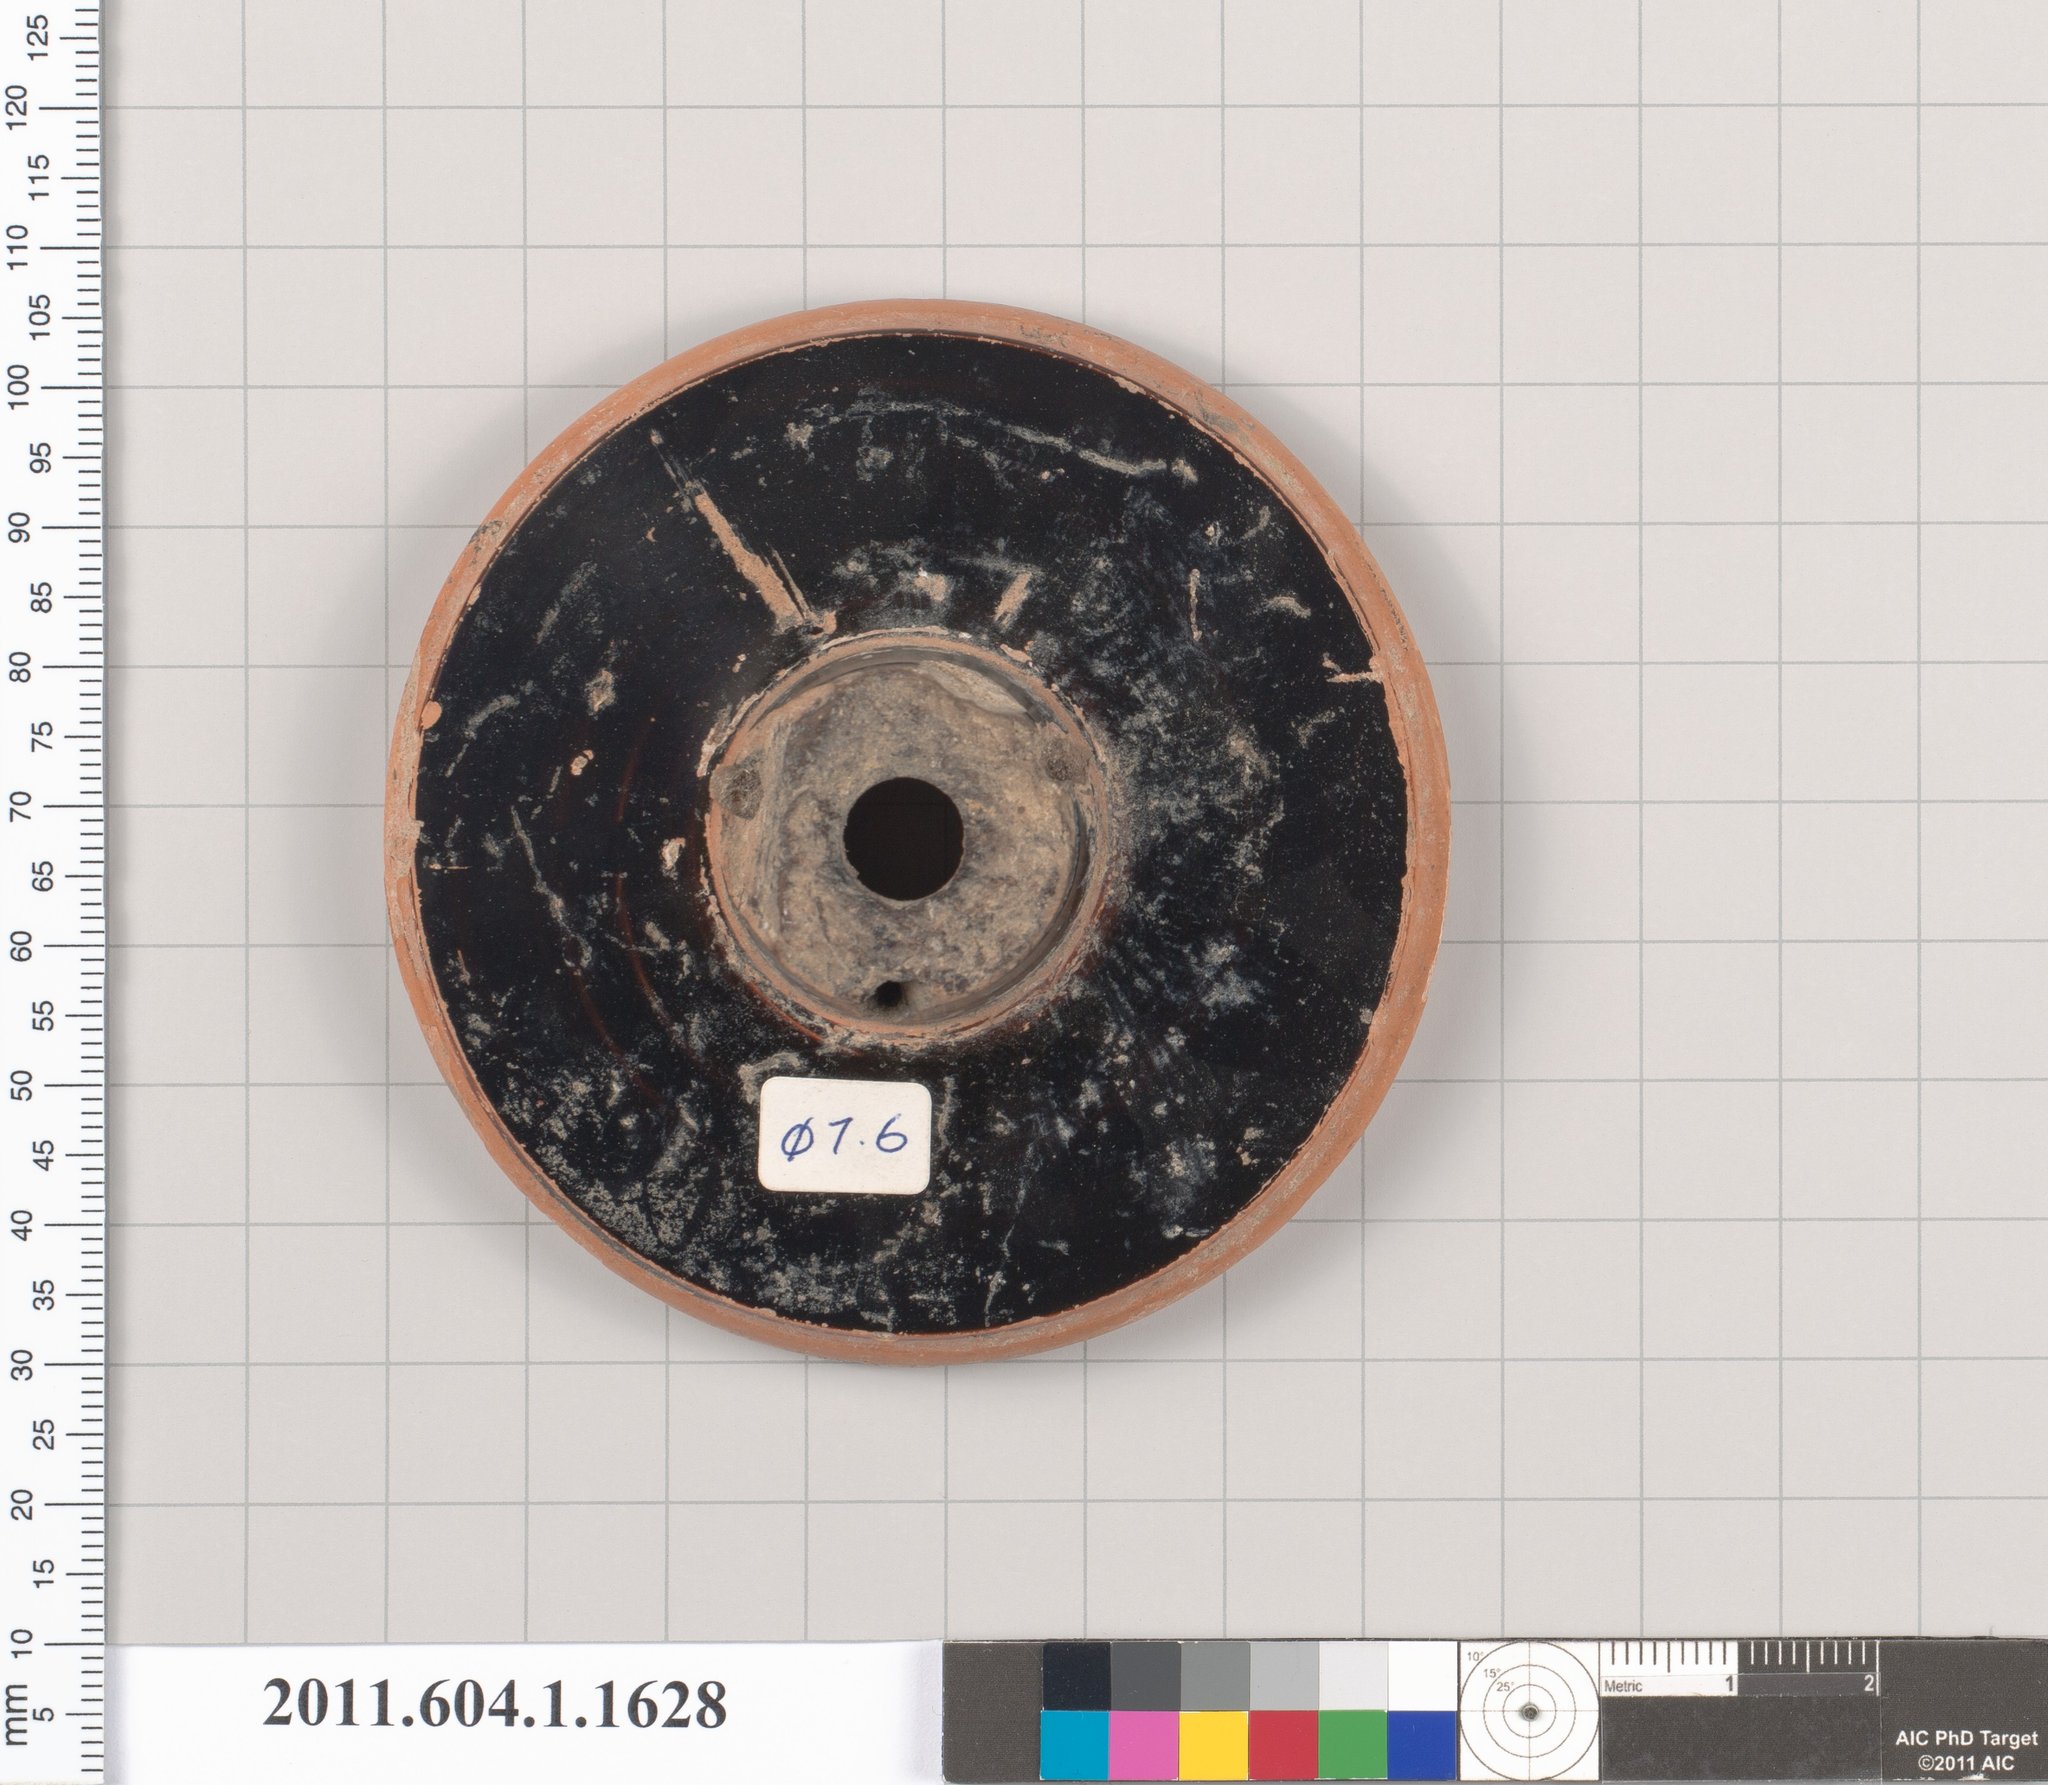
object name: kylix fragment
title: Terracotta fragment of a kylix (drinking cup)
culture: greek, attic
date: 500-401 BCE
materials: terracotta